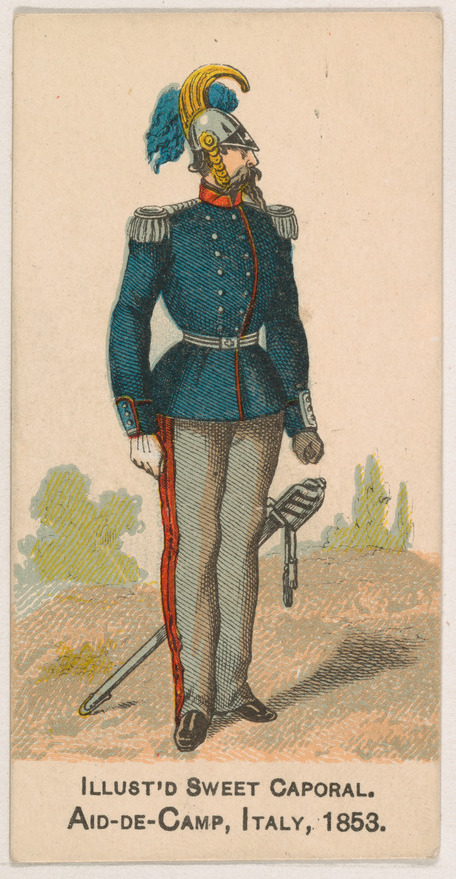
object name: print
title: Aid-de-Camp, Italy, 1853 from the Military Series (N224) issued by Kinney Tobacco Company to promote Sweet Caporal Cigarettes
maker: kinney brothers tobacco company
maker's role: publisher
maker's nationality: american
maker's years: 1869-2011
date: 1888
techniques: color lithograph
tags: military,men,profiles